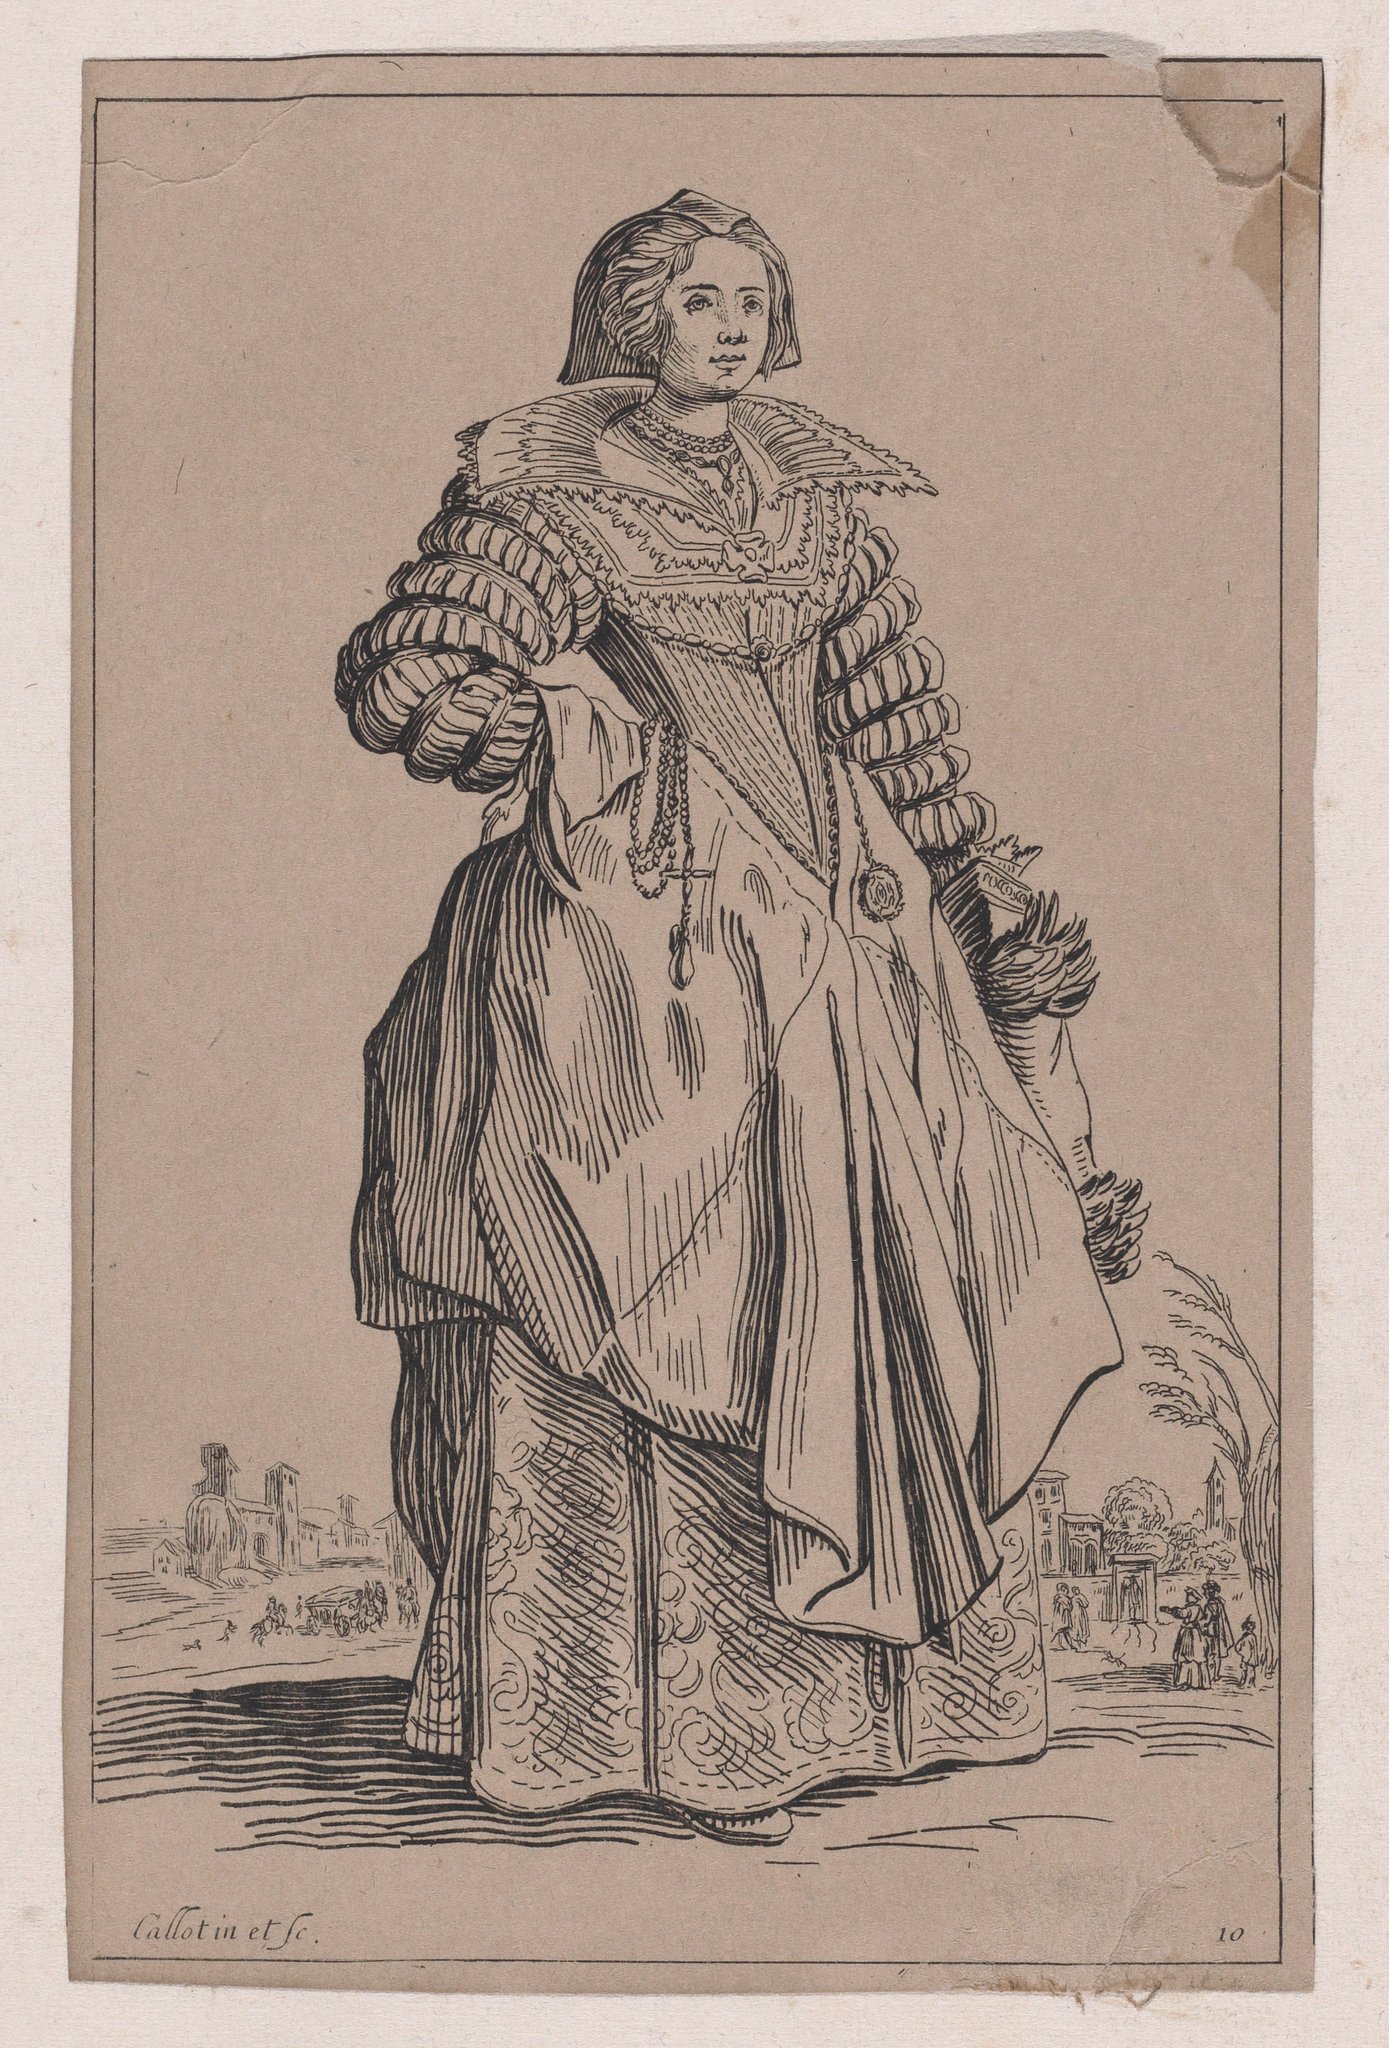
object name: print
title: Copy of La Dame a la Grande Collerette et a la Coiffe Retombant en Arrière (The Lady with the Large Collar and a Headdress that Falls to the Back), from "La Noblesse" (The Nobility)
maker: Anonymous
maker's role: artist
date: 1601-1700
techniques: etching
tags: women